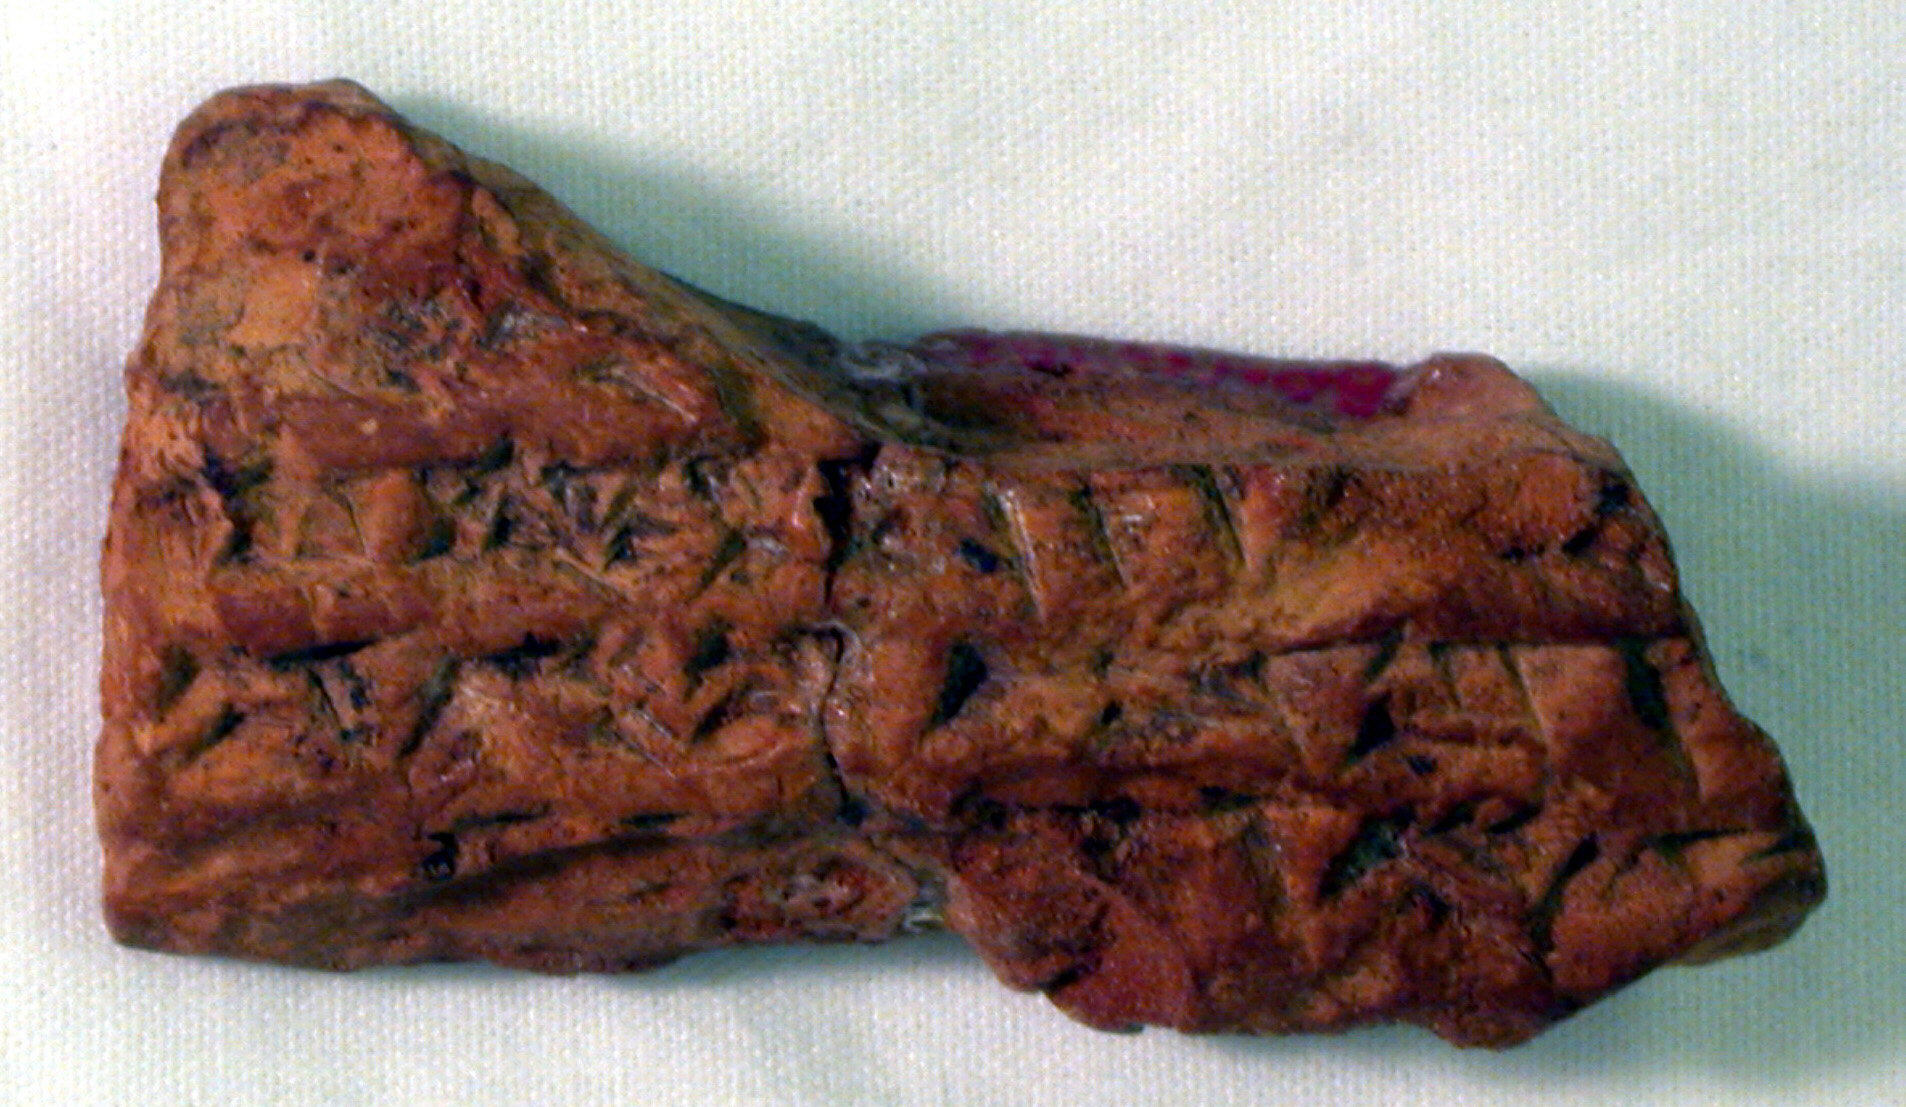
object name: cuneiform tablet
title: Cuneiform tablet: fragment of an accounting record (?)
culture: achaemenid or babylonian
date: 700-301 BCE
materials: clay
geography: mesopotamia